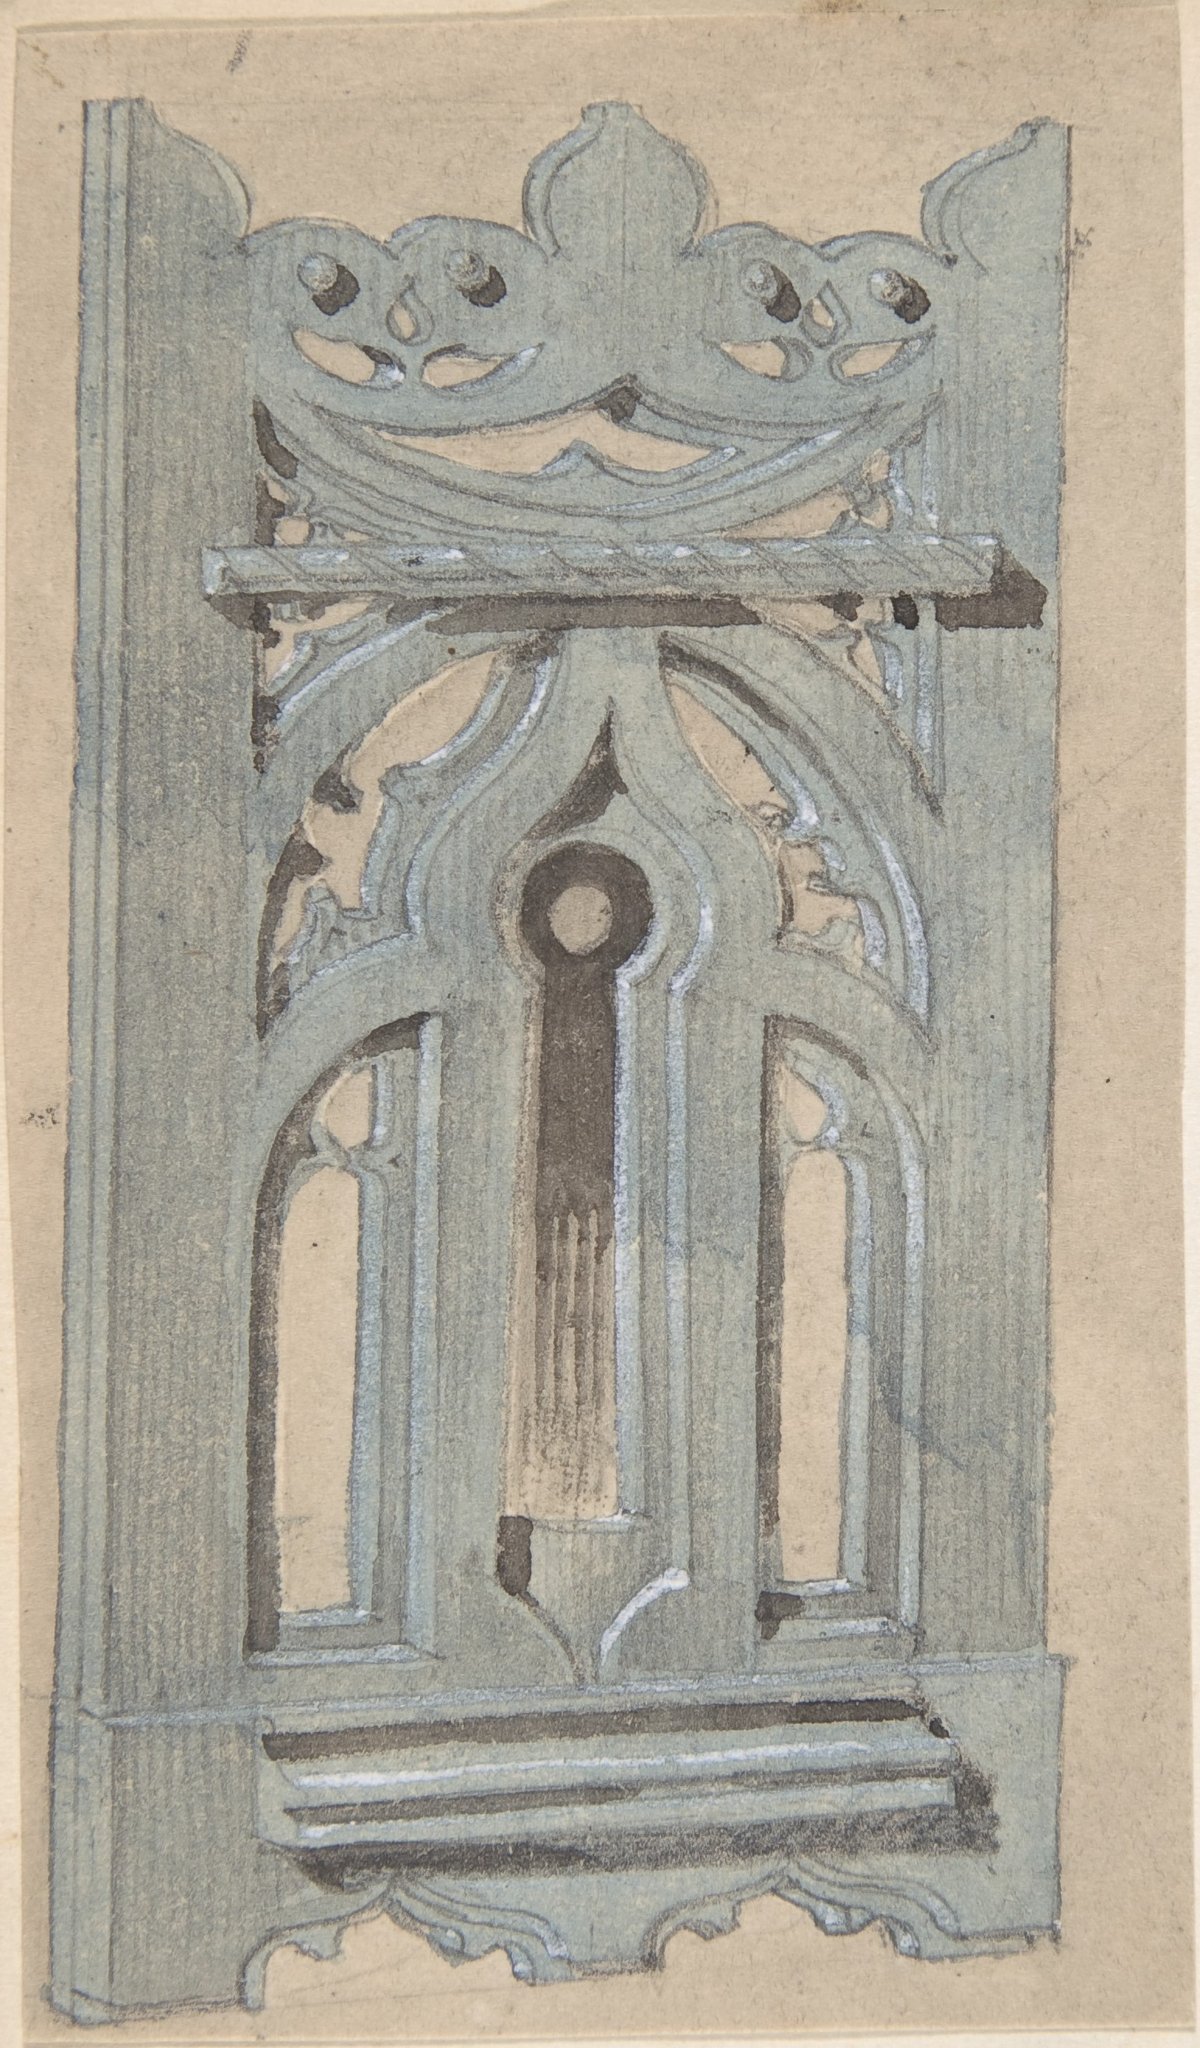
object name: drawing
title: Metal Keyplate for Church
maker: anonymous, british, 19th century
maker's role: artist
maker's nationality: british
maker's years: 1800-1900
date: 1851-1900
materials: gouache